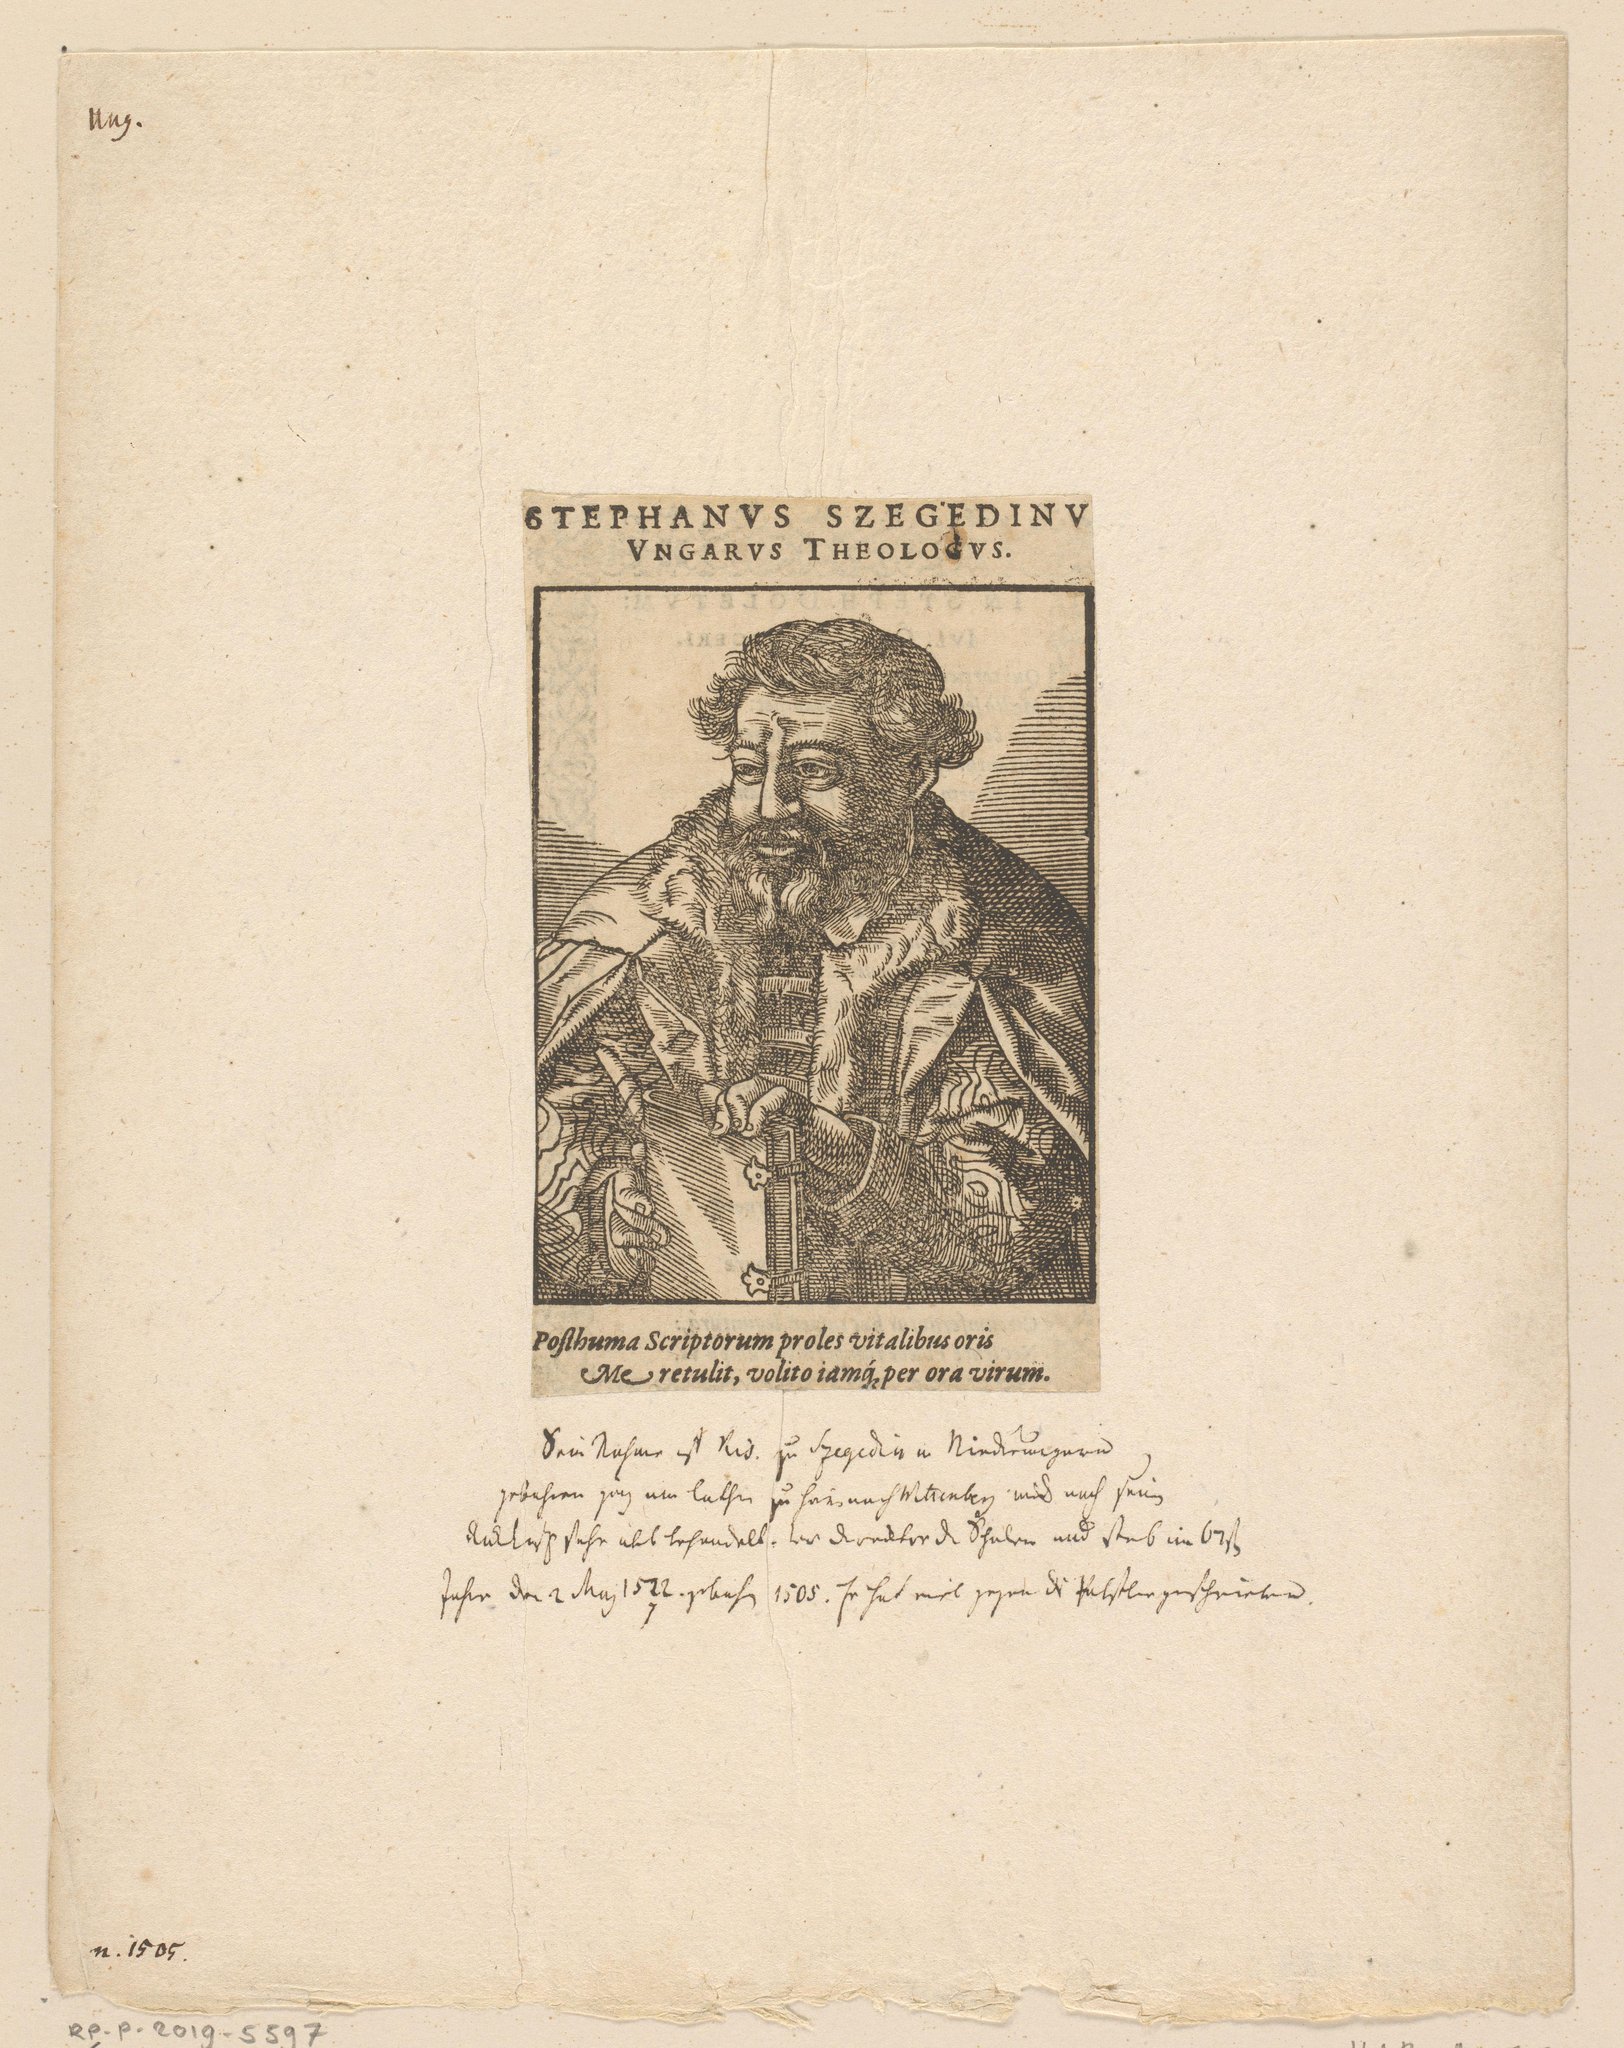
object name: book illustration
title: Portret van Stephanus Szegedinus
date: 1589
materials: paper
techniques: letterpress printing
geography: basel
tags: theologian, historical persons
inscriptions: inscription: ‘[...]’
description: Prent uit: Zwinger, Theodor. Icones aliquot clarorum virorum Germaniae, Angliae, Galliae, Ungariae: cum (...). Bazel: Konrad Waldkirch, 1589. Prent mogelijk ook gebruikt in eerdere en latere publicaties.